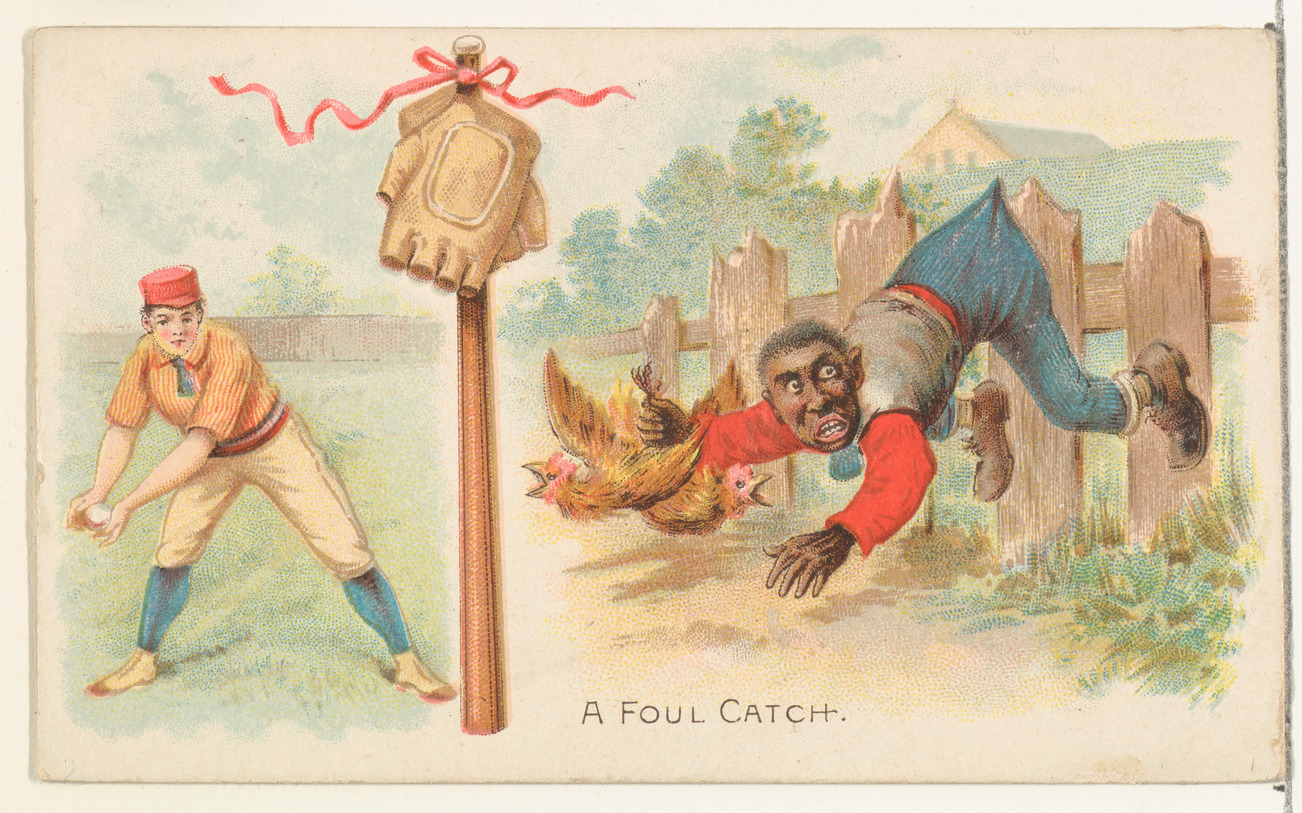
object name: print, baseball card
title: A Foul Catch, from the Talk of the Diamond set (N135) issued by Duke Sons & Co., a branch of the American Tobacco Company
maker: w. duke, sons & co.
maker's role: publisher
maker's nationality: american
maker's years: 1870-1920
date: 1888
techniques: color lithograph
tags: men,baseball,athletes